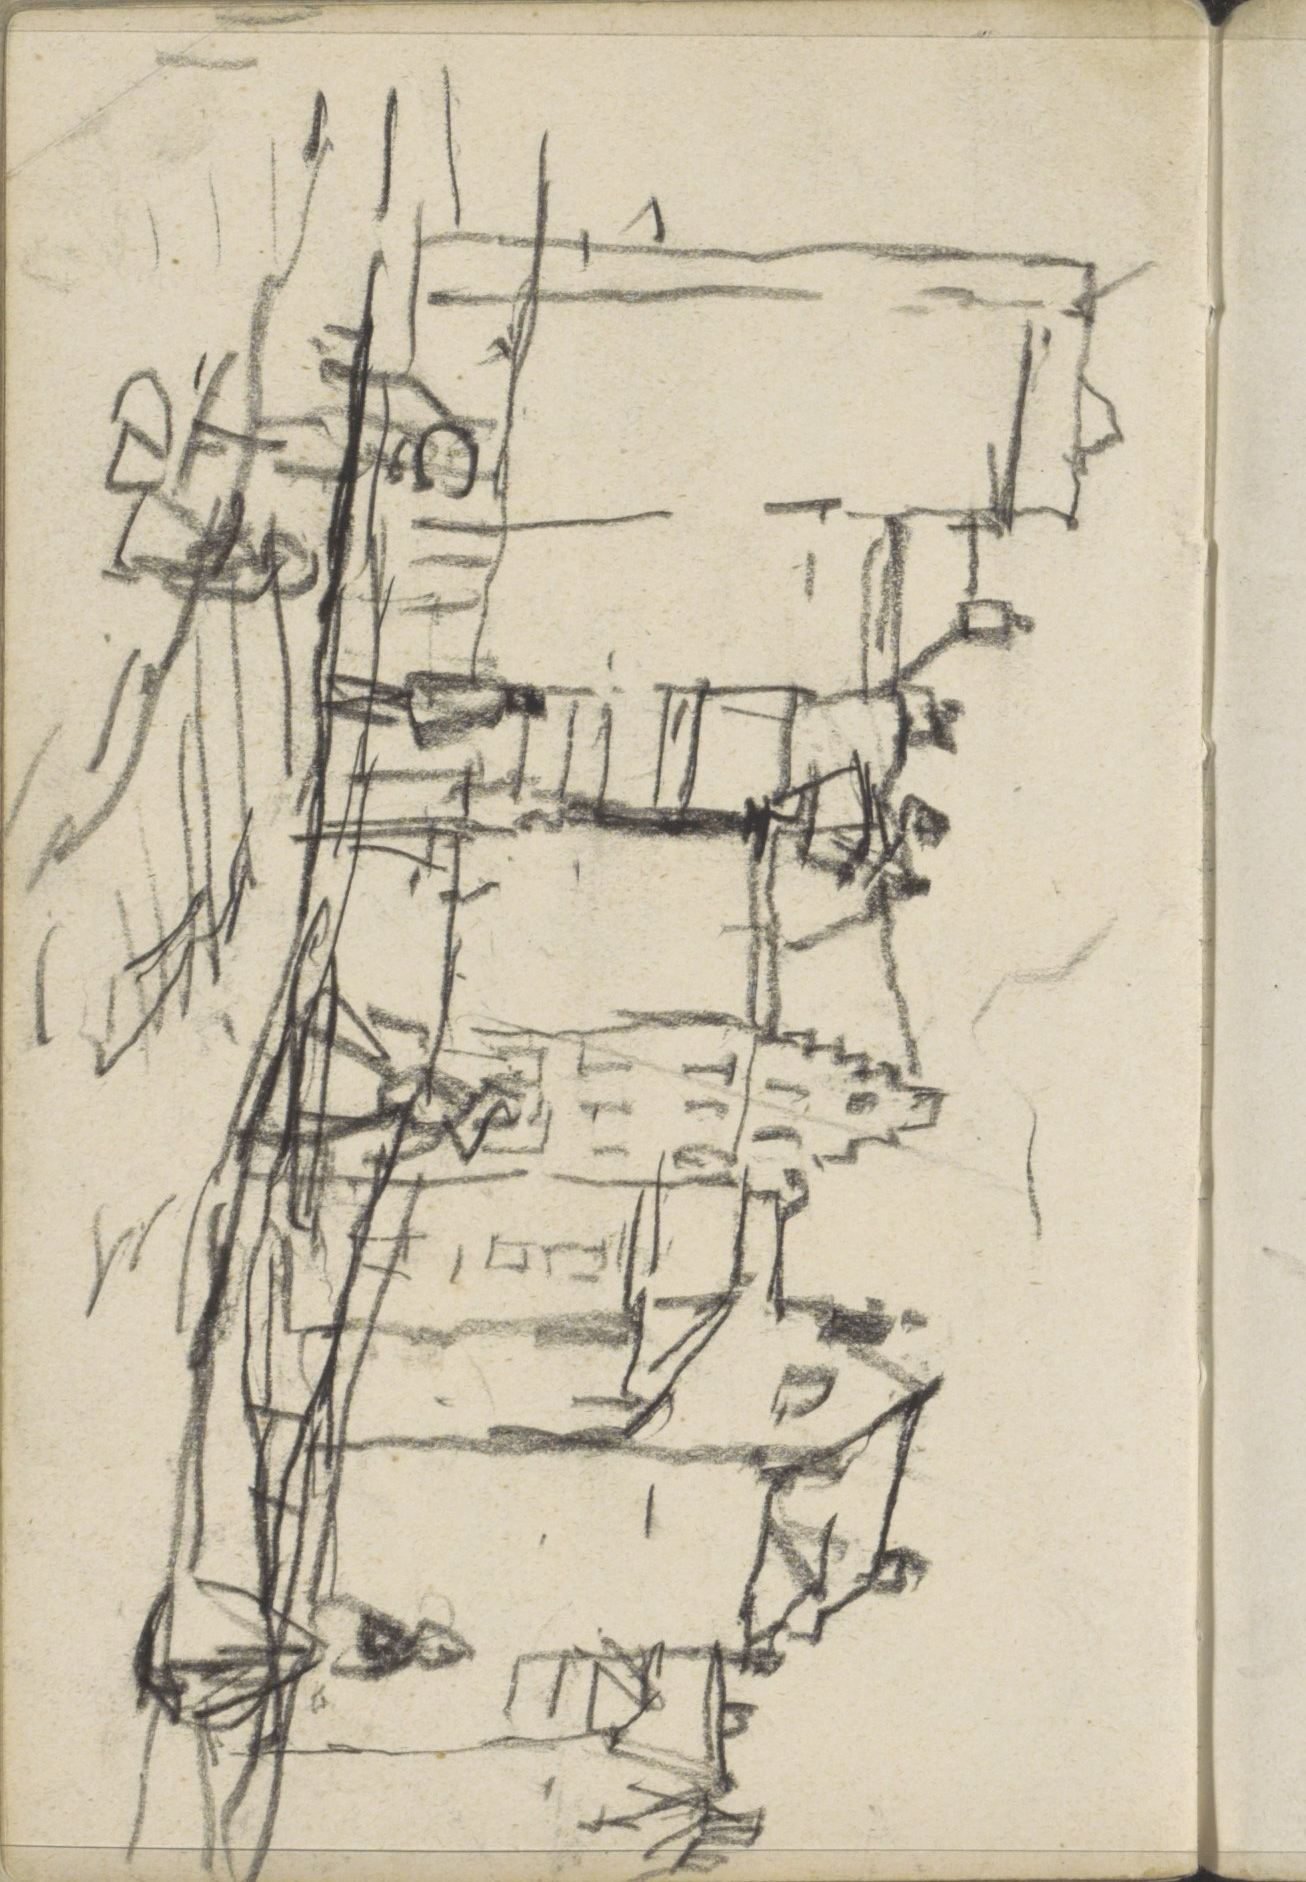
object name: sketchbook leaf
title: Gezicht op het Damrak te Amsterdam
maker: george hendrik breitner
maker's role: draughtsman, painter, print maker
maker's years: 1857-1923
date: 1909-1912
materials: chalk, paper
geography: amsterdam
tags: urban housing, canals, waters (in city), bridge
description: Gezicht op het Damrak te Amsterdam met de achterzijde van de panden aan de Warmoesstraat, waaronder het theemagazijn van Snel. Vooraan figuren op de brug. Pagina 91 uit een schetsboek met 46 bladen vervaardigd te Amsterdam.